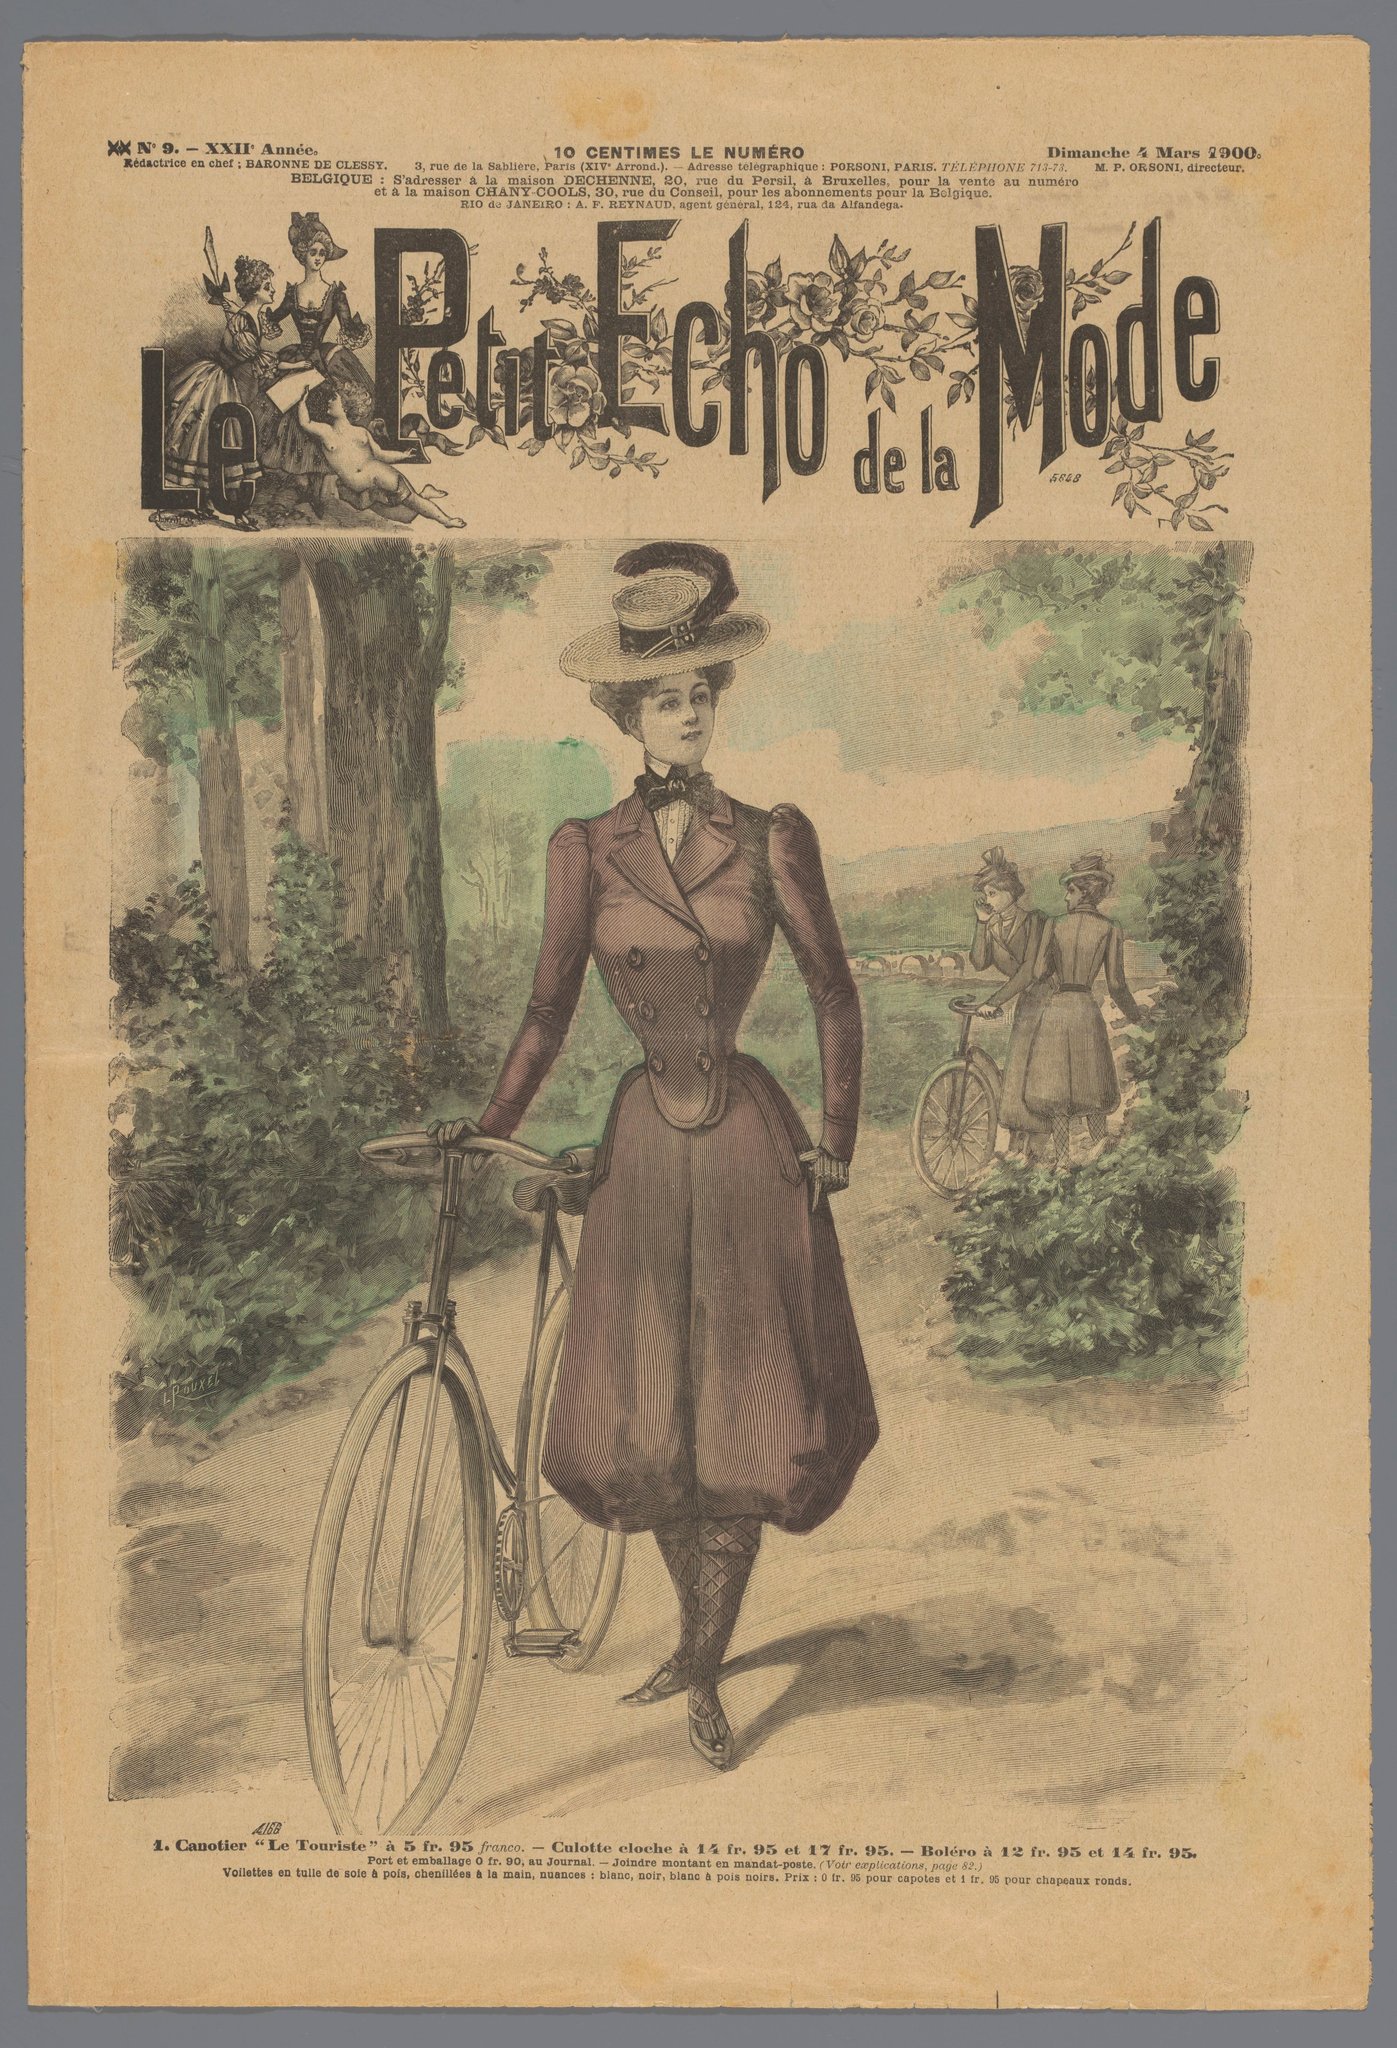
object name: fashion print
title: The Fashion Magazine as Temptress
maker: Anonymous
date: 1905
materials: paper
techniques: engraving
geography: paris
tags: ensembles of pieces of clothing (two piece suit) (+ women's clothes), head-gear: hat (+ girls' clothes), clothing for the upper part of the body (bolero) (+ women's clothes), coat: overcoat (+ girls' clothes), fashion plates, head-gear: hat (+ women's clothes), dress, gown (+ girls' clothes)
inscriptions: caption (): ‘1. Canotier "Le Touriste"à 5 fr. 95 - Culotte cloche à 14 fr.95 et 17. fr.95- Boléro à 12 fr. 95 et 14.fr 95.’, title (false): ‘La Mode du Petit Journal: supplement, Nr. 43. - Dimanche 4 Mars 1900’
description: The first fashion magazines were sold only by subscription. They have nondescript covers, with neither text nor image. This changed at the end of the 19th century when the publications came to be displayed in stands and shops. Publishers went to great lengths to entice potential buyers by means of attractive covers.